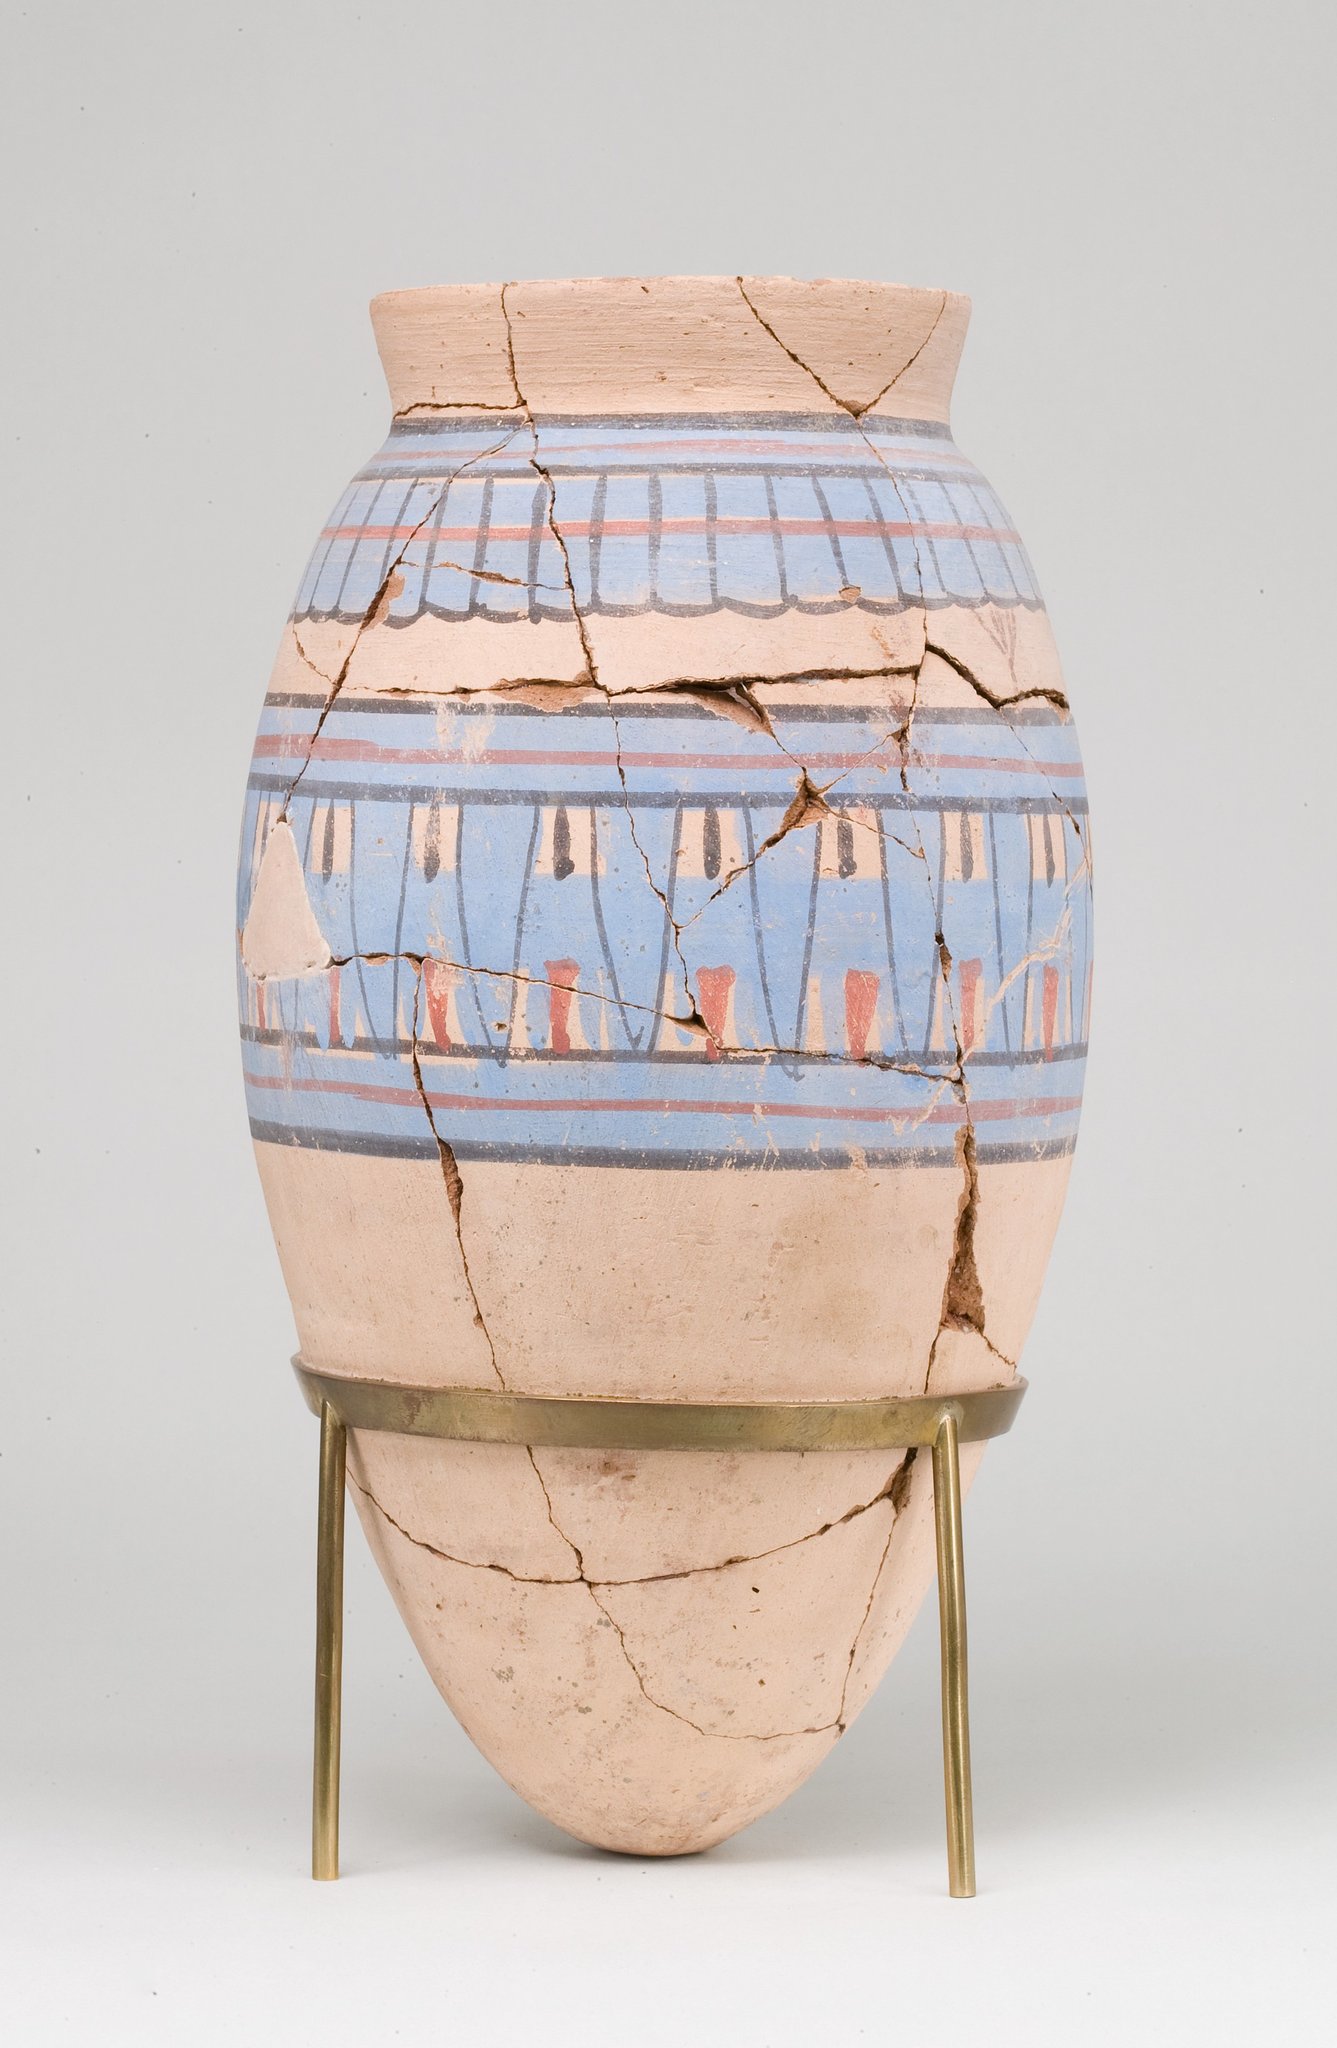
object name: jar, blue painted ware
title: Blue-painted Jar from Malqata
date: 1390-1352 BCE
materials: paint, pottery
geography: egypt